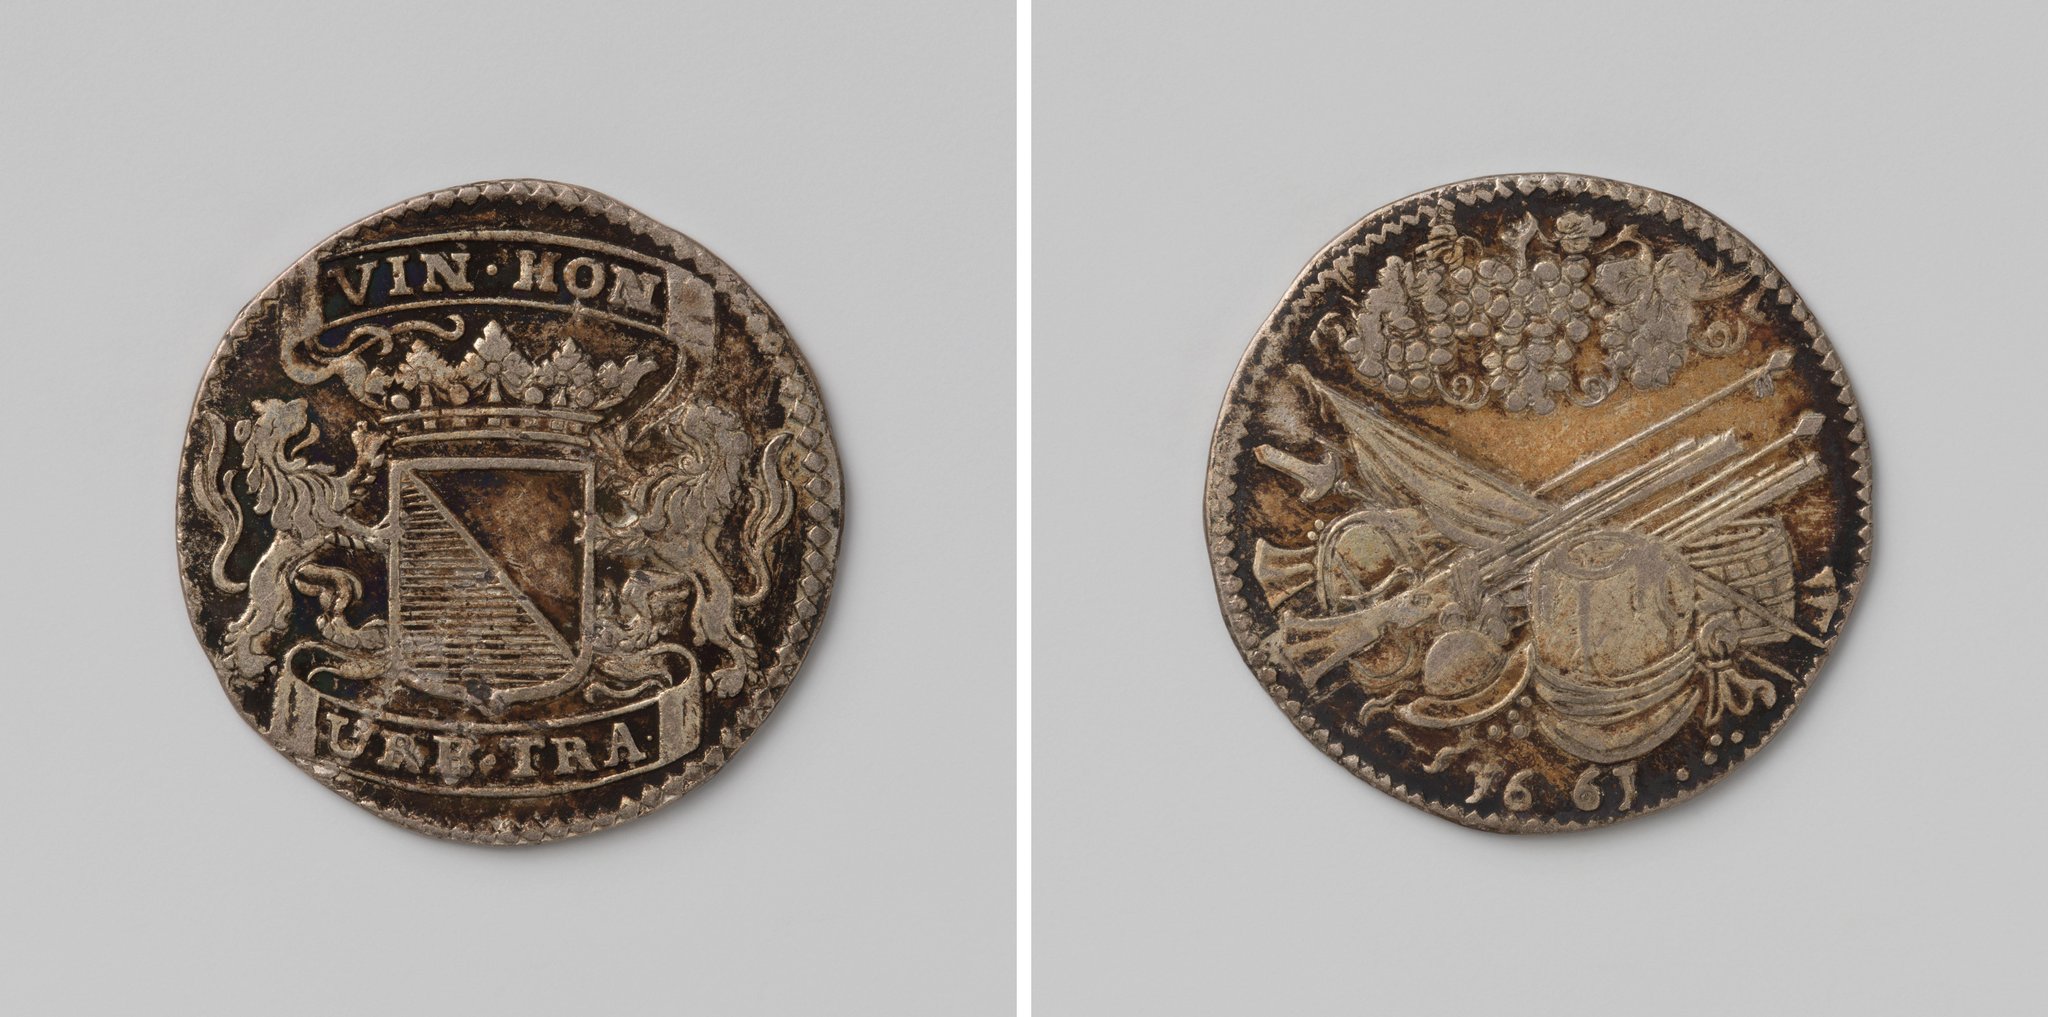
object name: marksman medal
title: Schutterij van Utrecht, penning die schutters recht gaf op een kan wijn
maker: roelof van cuylenburch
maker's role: goldsmith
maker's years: 1607-1673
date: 1661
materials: silver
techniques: striking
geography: utrecht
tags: utrecht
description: Zilveren wijn- en schutterspenning van Utrecht. Voorzijde: gekroond wapenschild, geflankeerd door twee leeuwen onder en boven wimpel met opschrift. Keerzijde: druiventros boven wapentrophee bestaande uit harnas, vaandels, trom en wapentuig; daaronder: jaartal